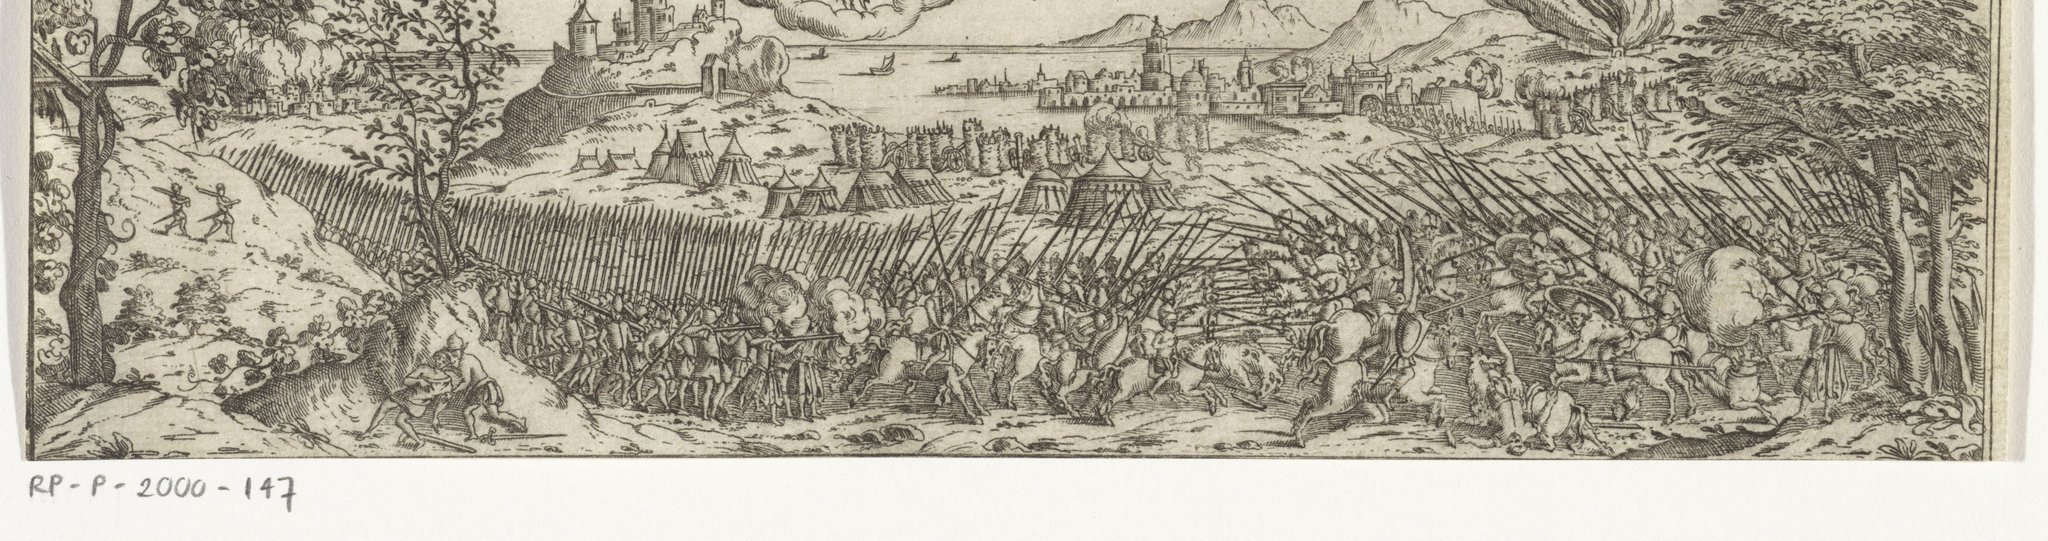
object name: print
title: Juni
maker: Anonymous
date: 1554-1641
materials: paper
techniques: etching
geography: netherlands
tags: june and its 'labours' (+ with zodiacal signs)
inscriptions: collector's mark: Lugt 2228, collector's mark: Lugt 2760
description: Bezigheden in de maand juni. Vooraan een veldslag tussen twee legers. In de verte een tentenkamp aan de voet van een heuvel met een kasteel. Rechtsachter staat een burcht in brand. In de lucht het dierenriemteken Kreeft.